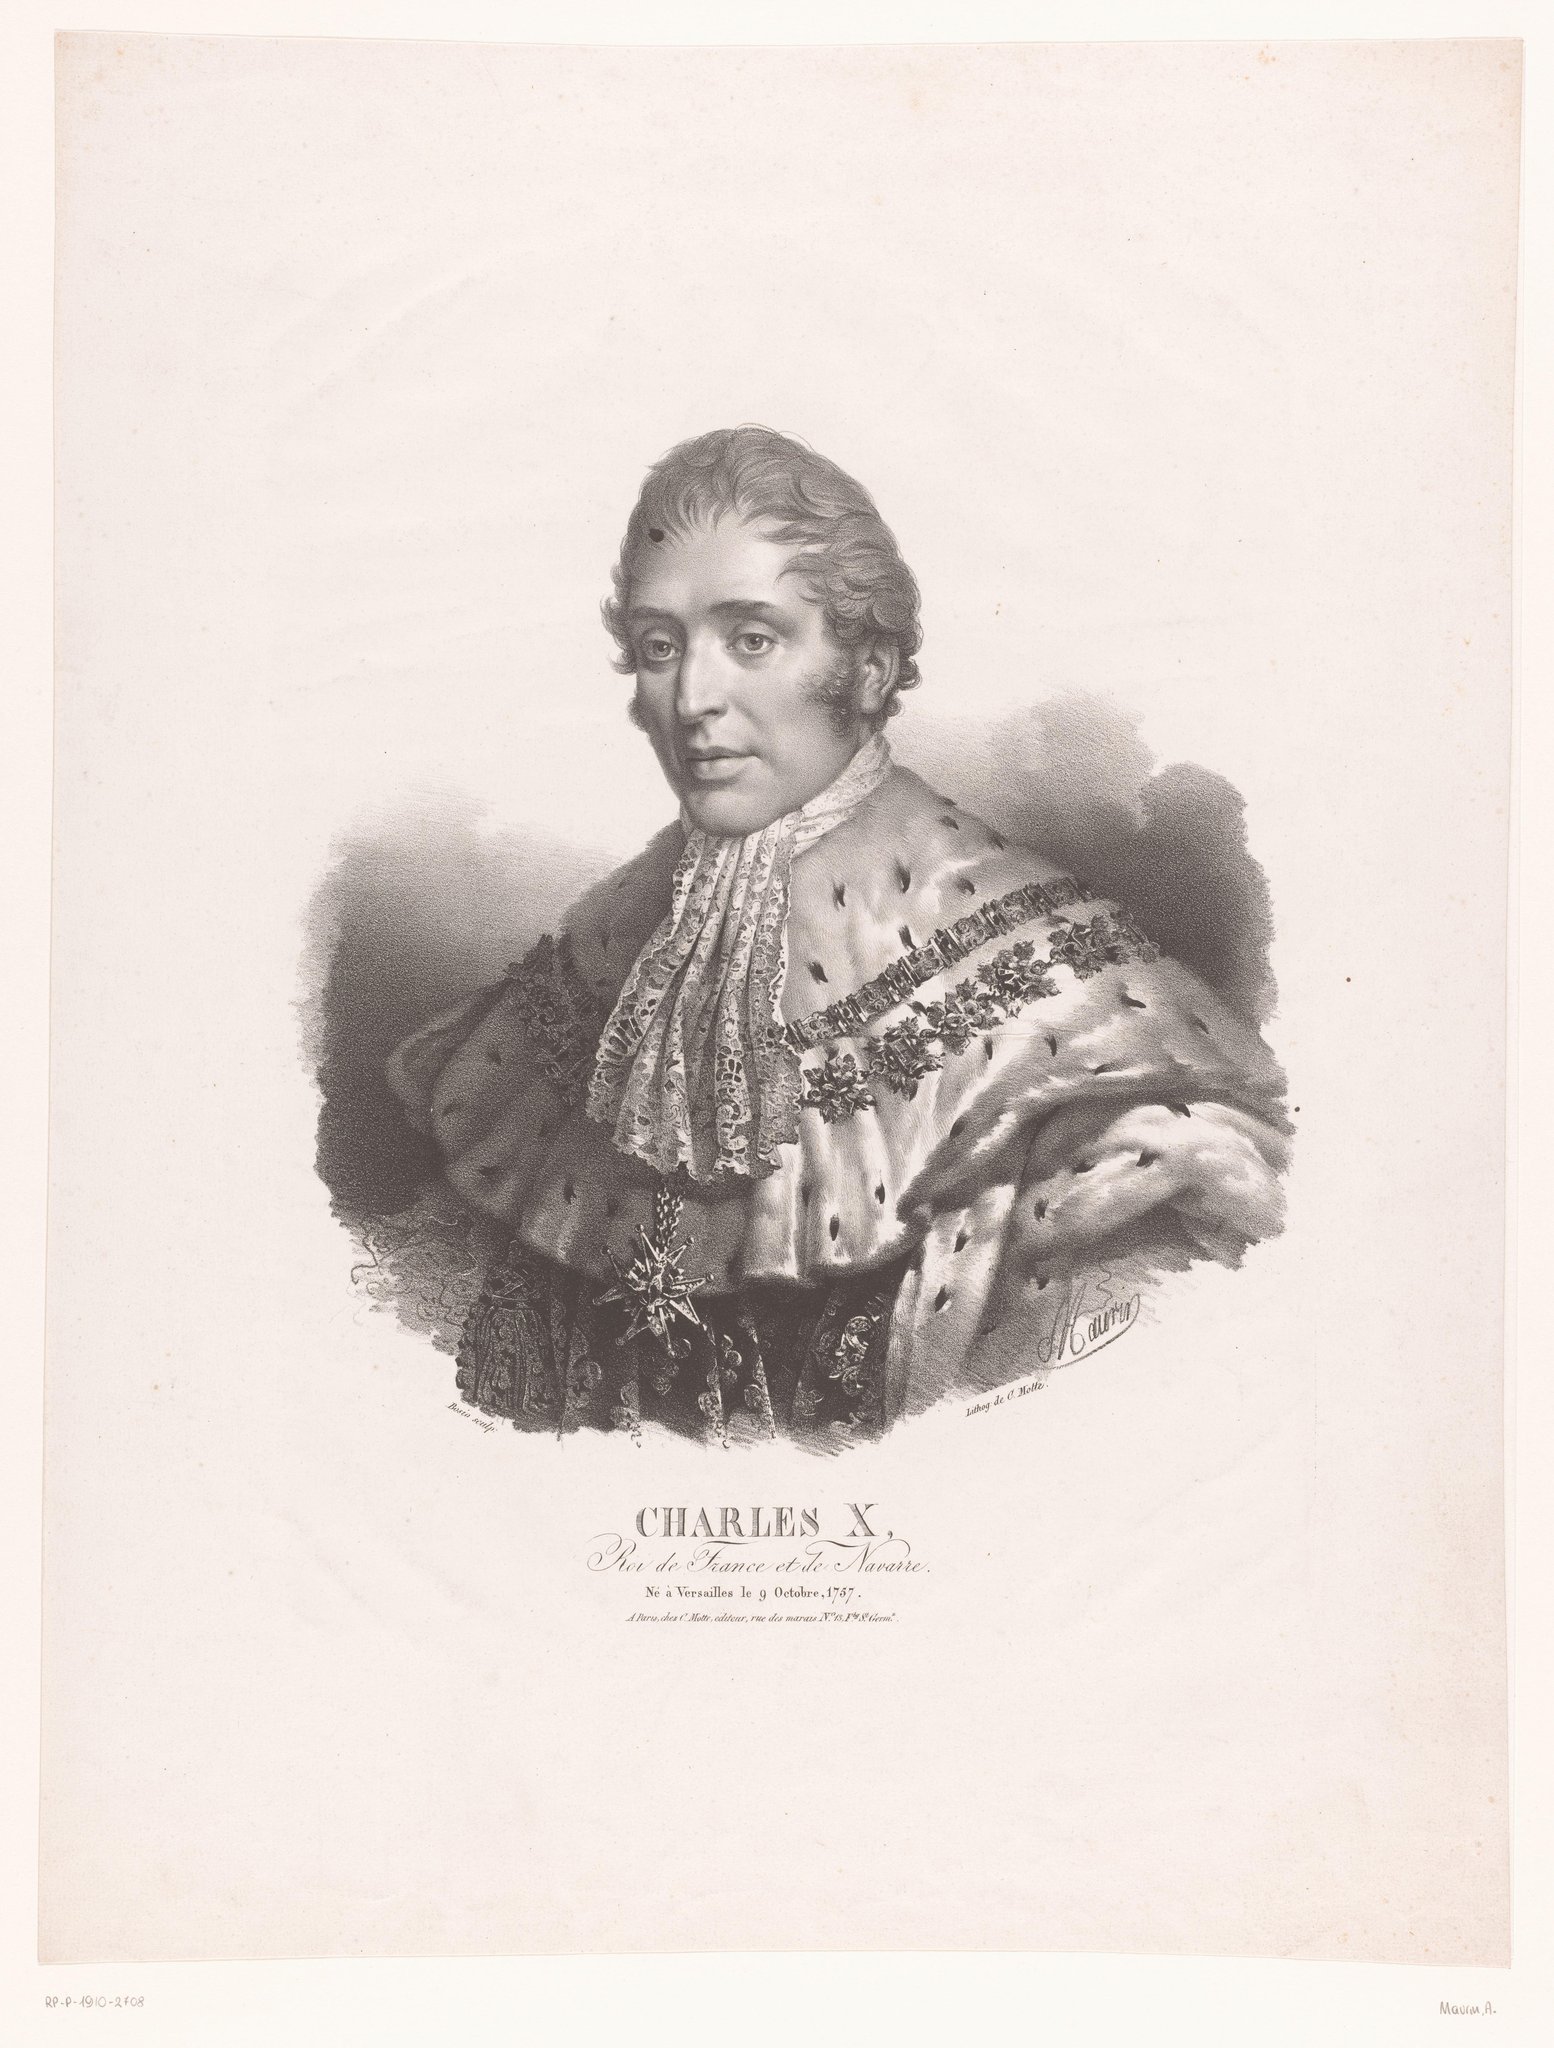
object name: print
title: Charles X, roi de France et de Navarre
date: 1826-1837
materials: paper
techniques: lithograph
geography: paris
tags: historical persons, king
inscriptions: collector's mark: Lugt 2228